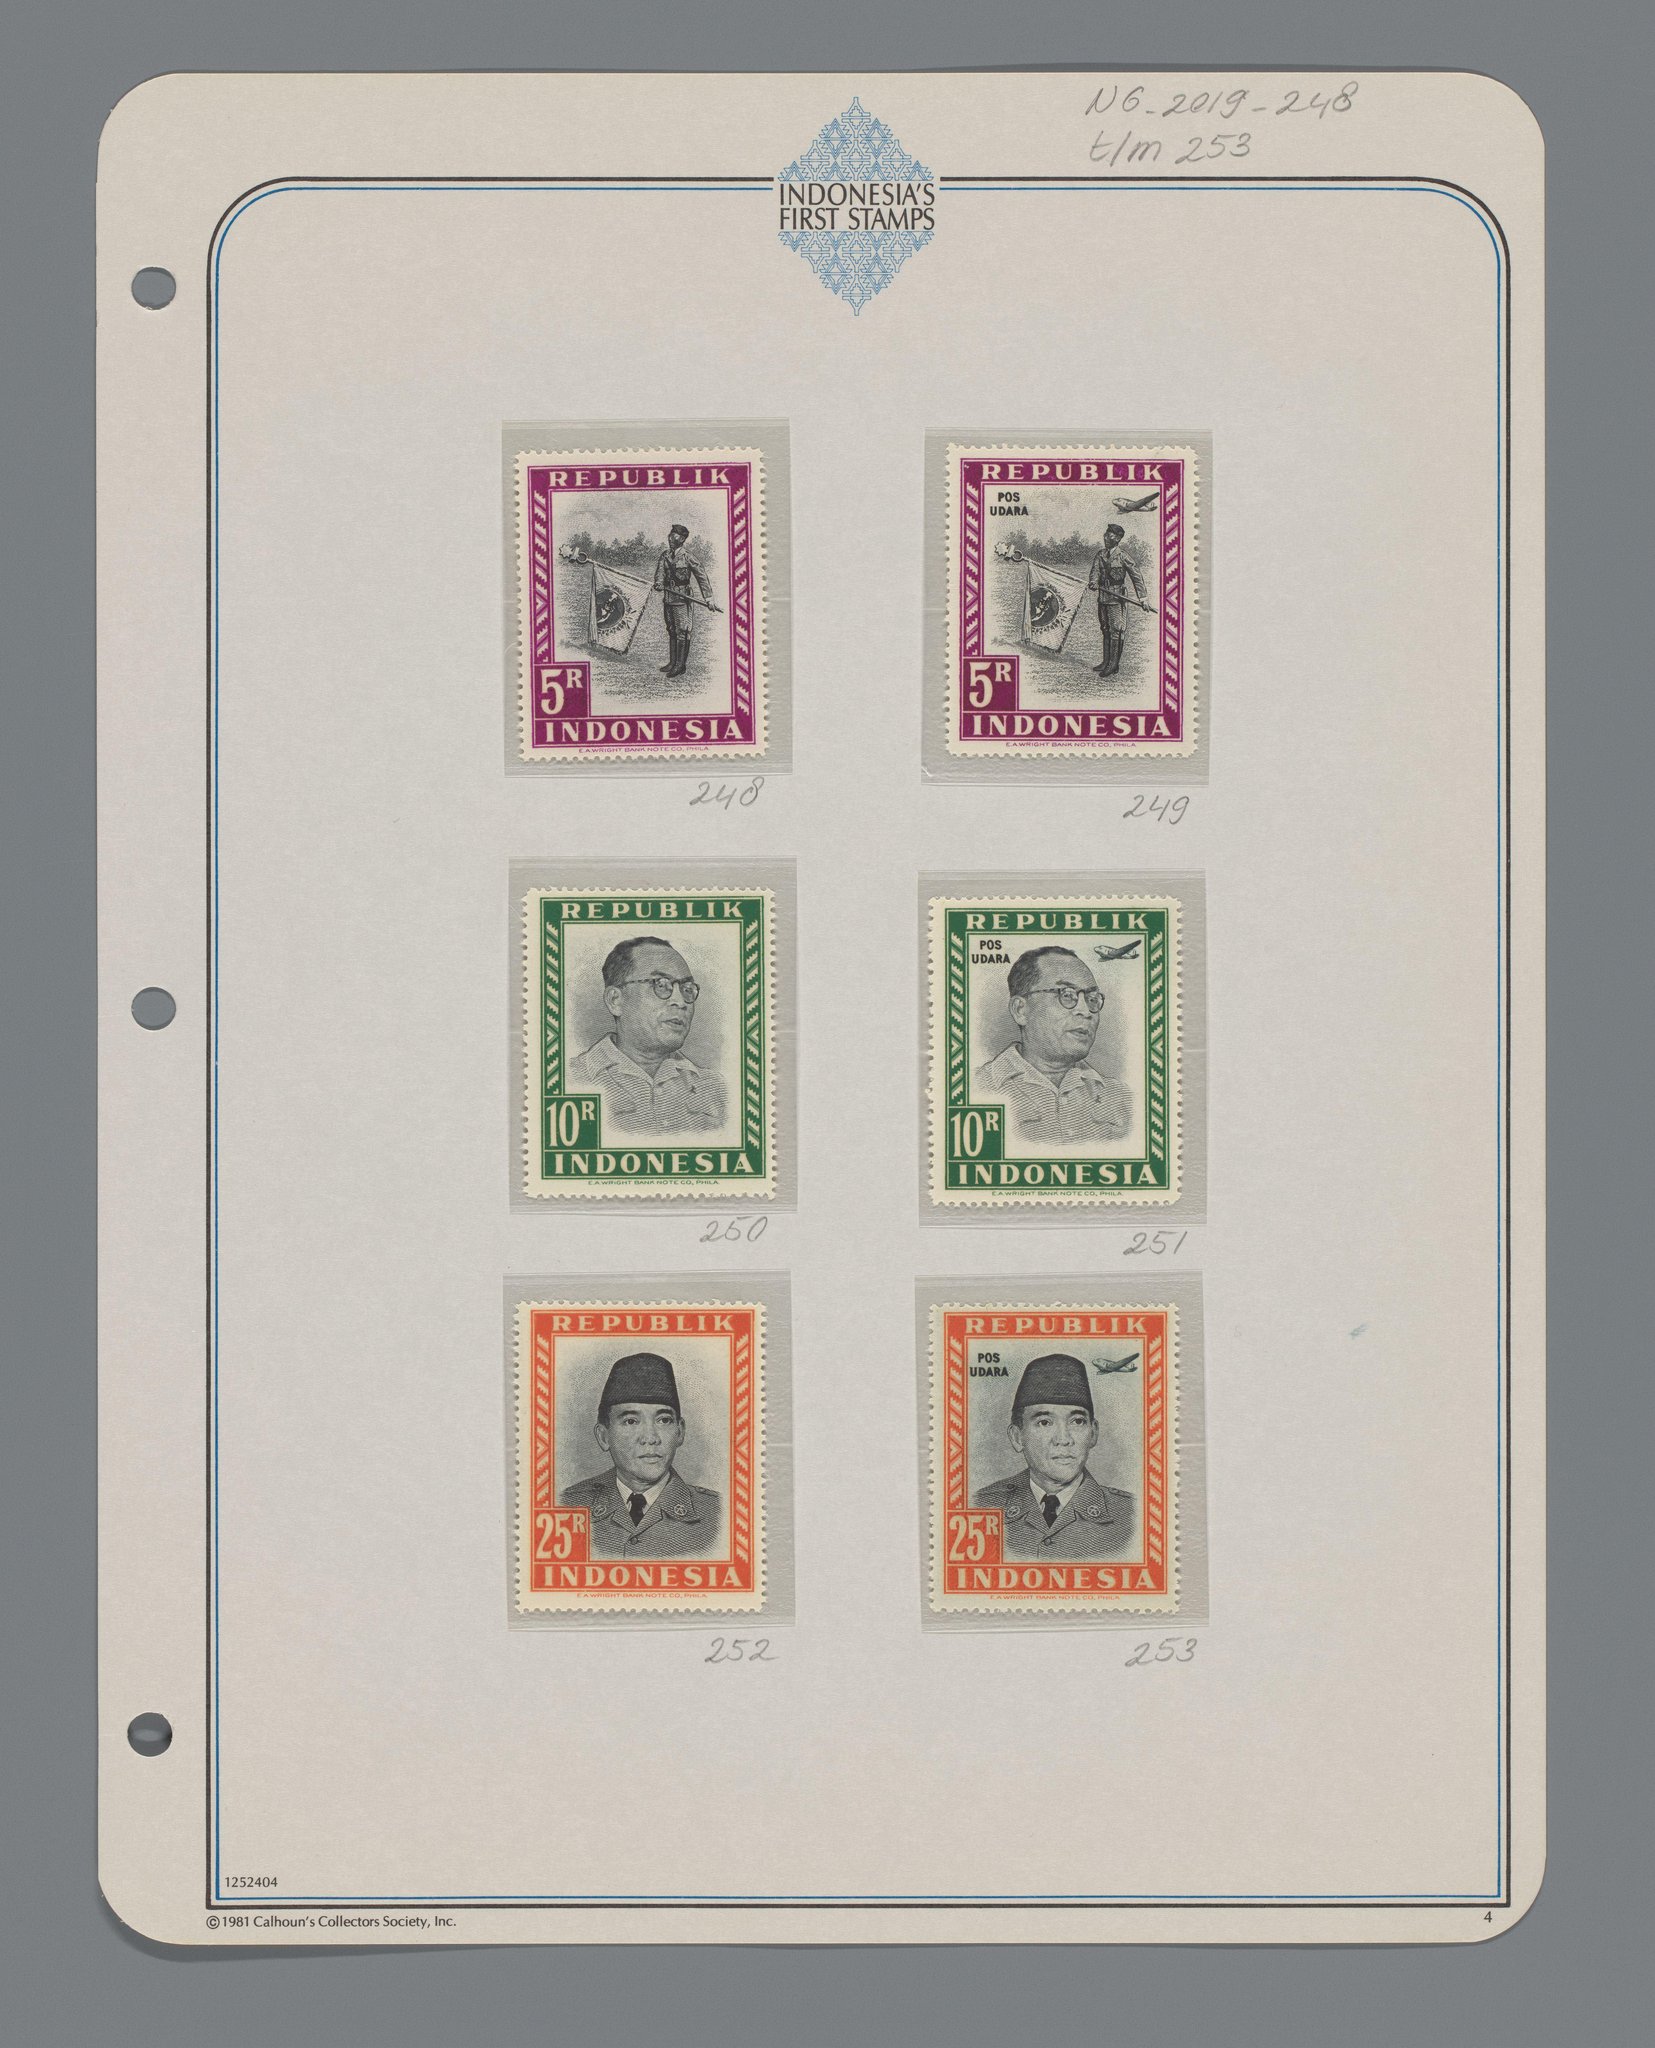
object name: postage stamp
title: Postzegel Republik Indonesia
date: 1949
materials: paper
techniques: photoaquatint, engraving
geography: vienna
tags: indonesia